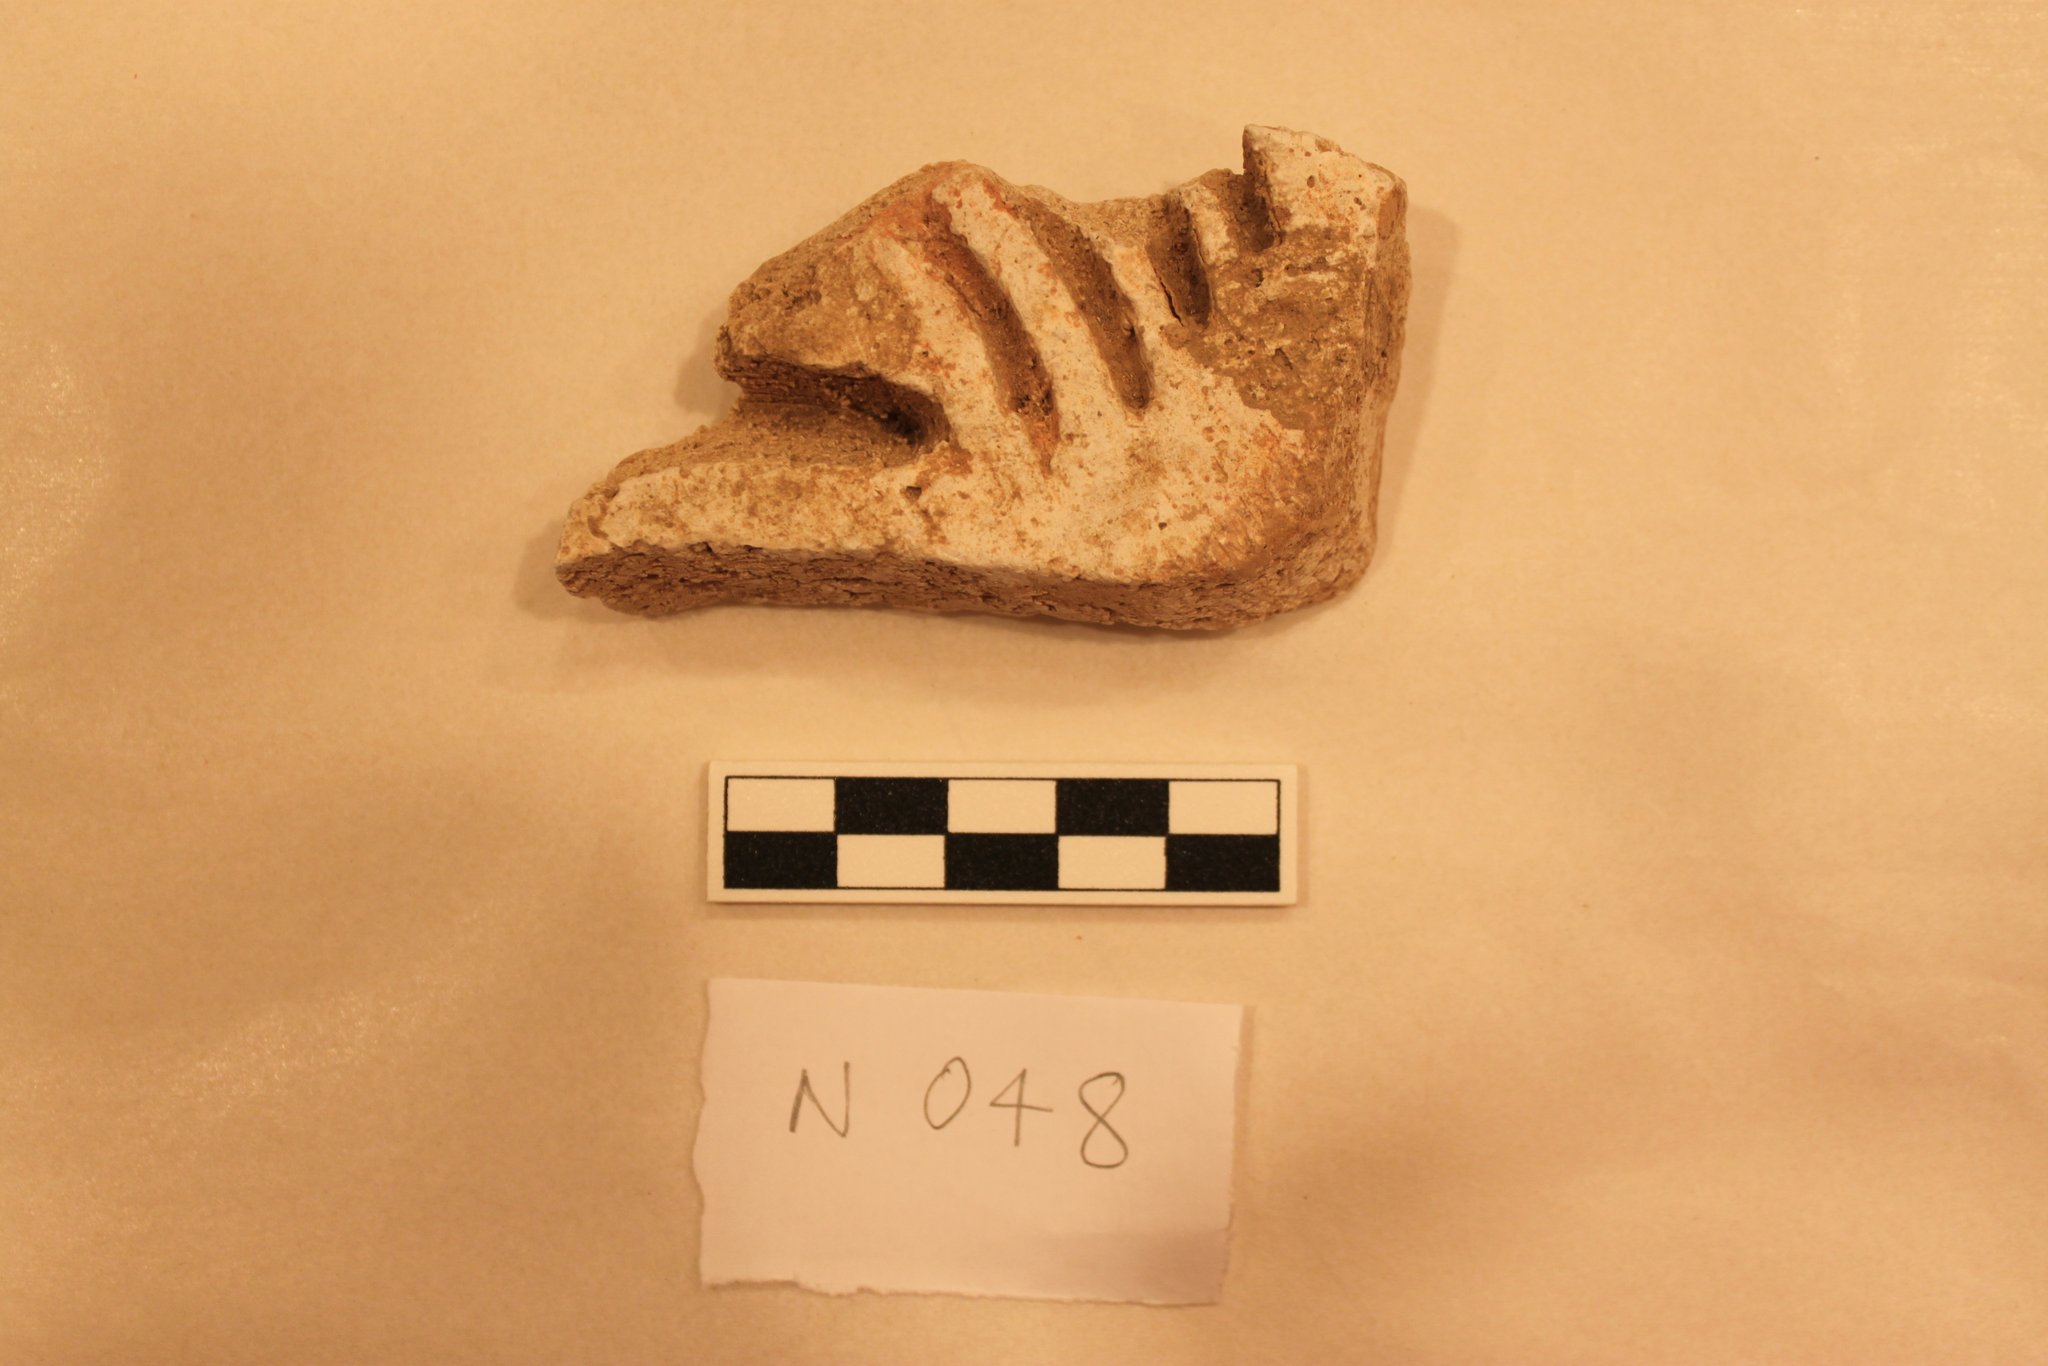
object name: fragment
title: Stucco Fragment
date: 701-1200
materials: plaster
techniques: carving, painting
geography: iran